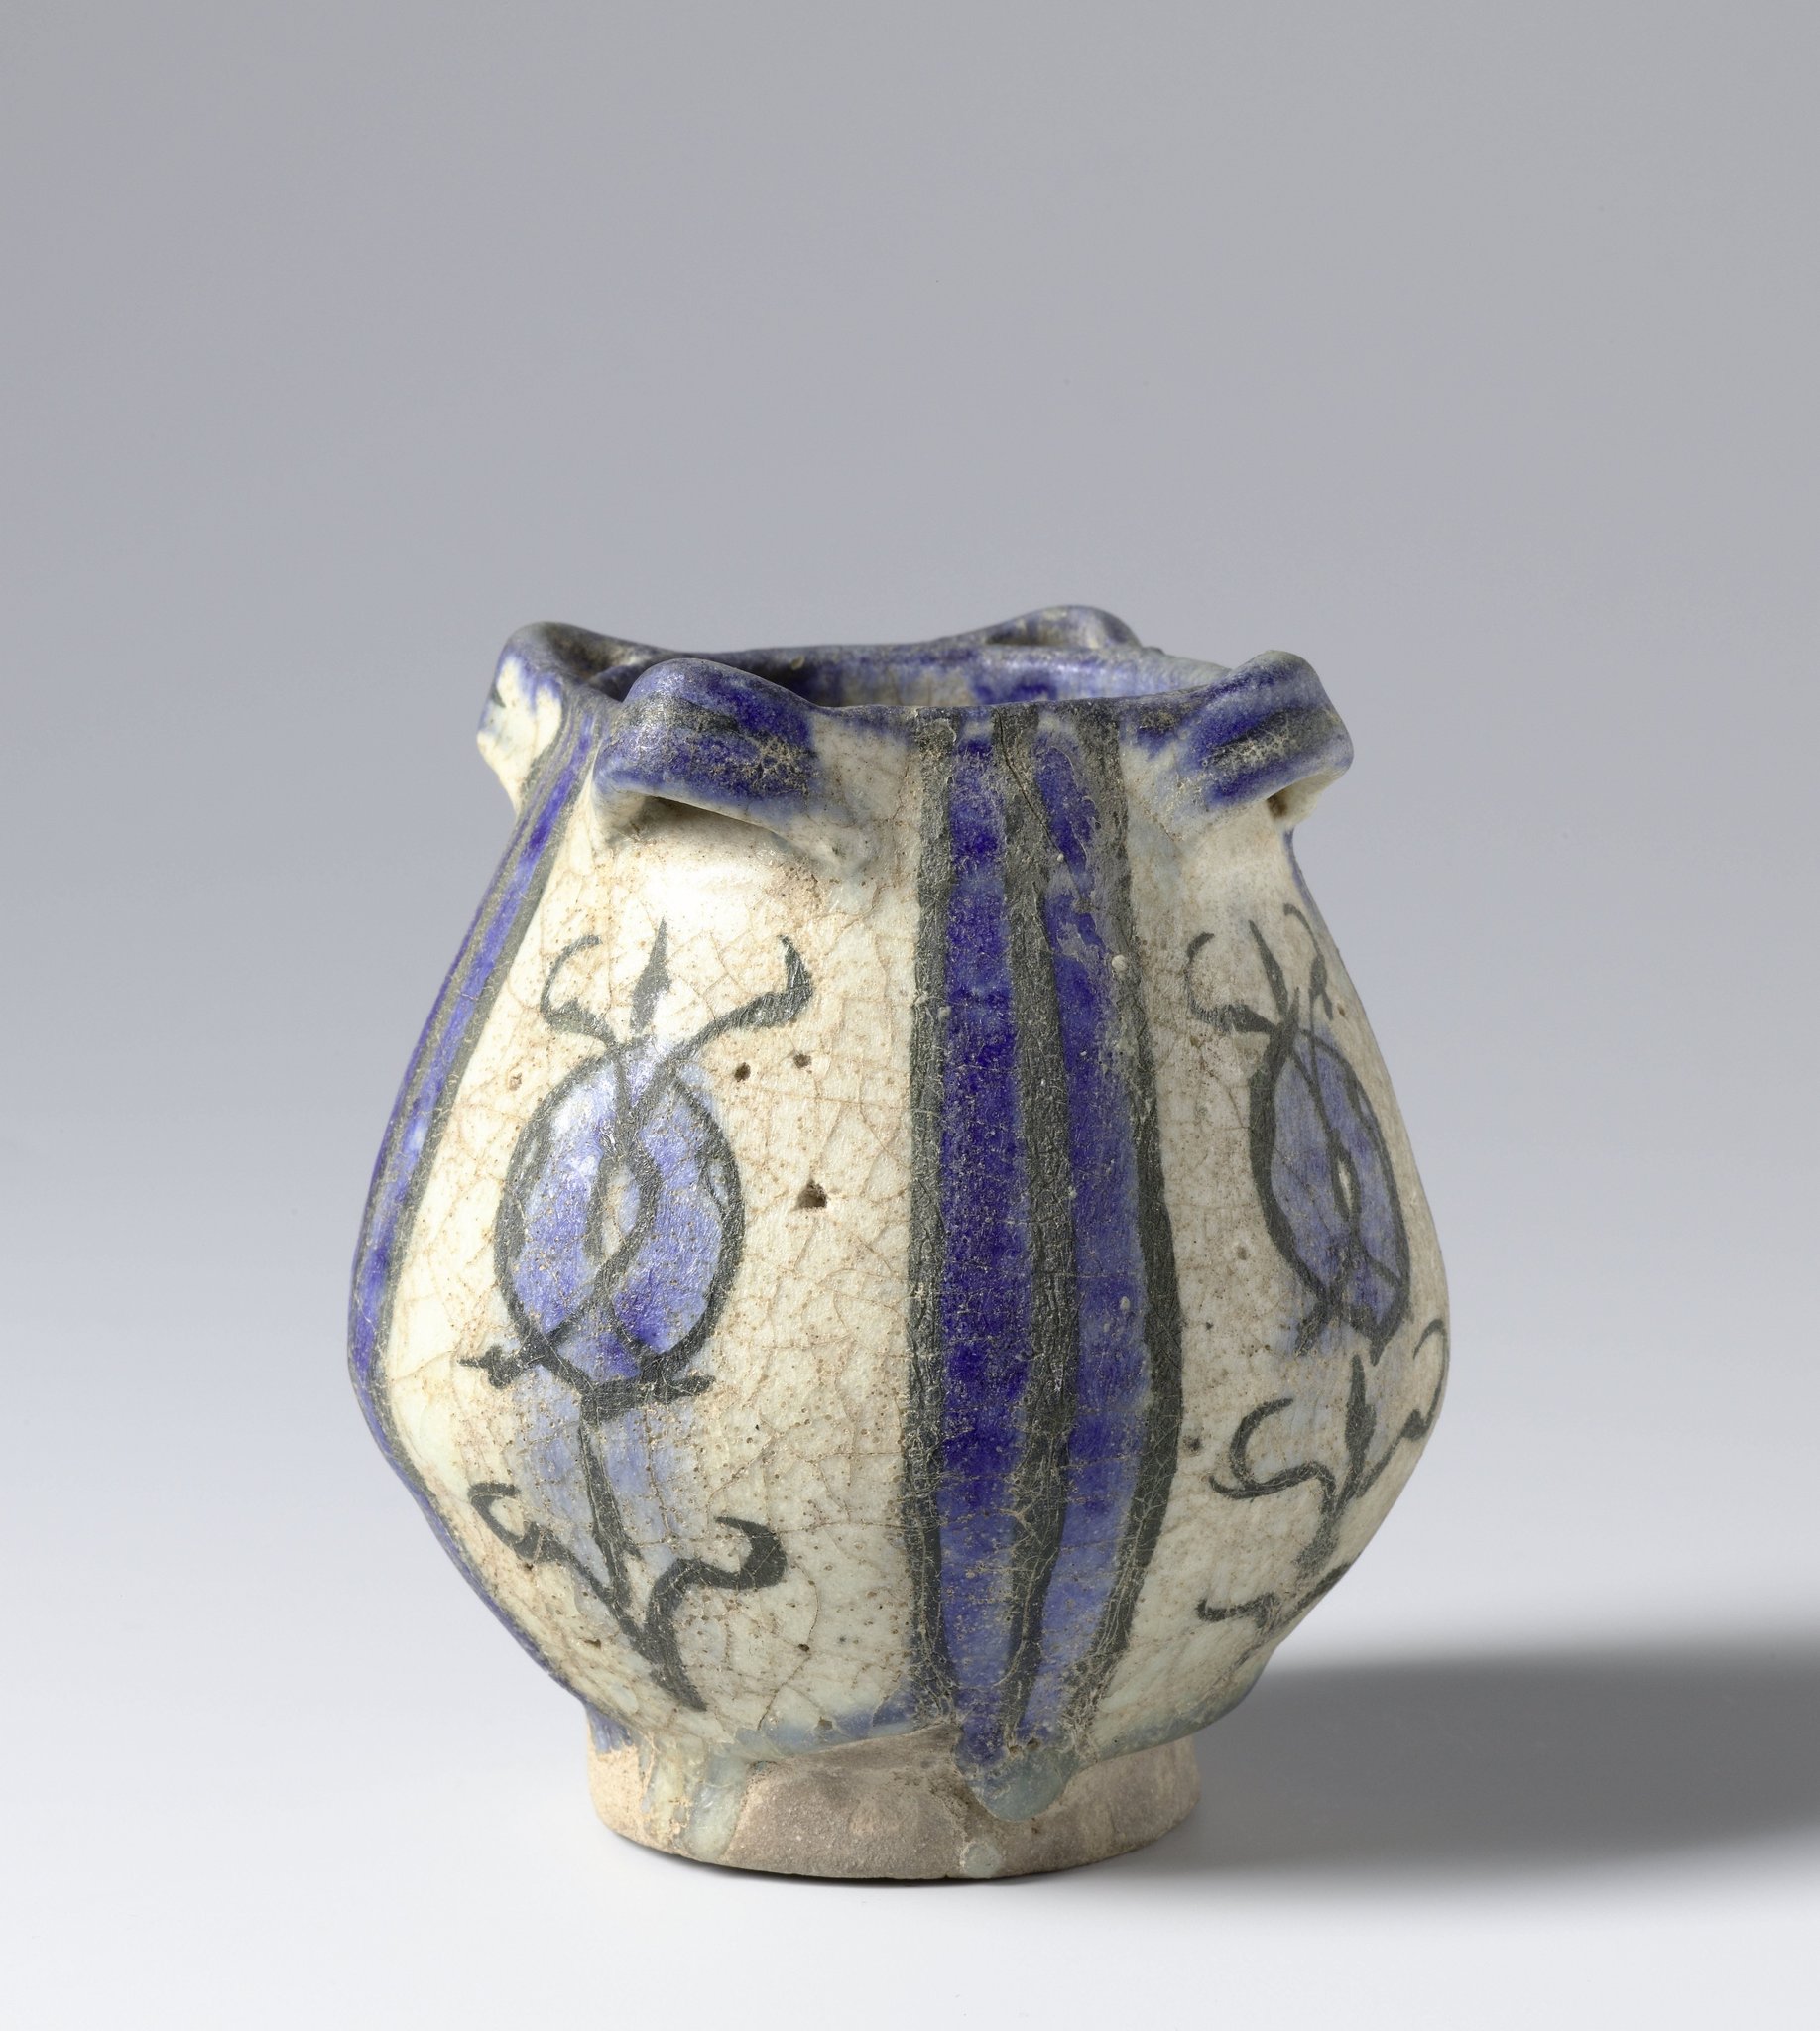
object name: bowl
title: Bowl with pseudo-inscription and stripes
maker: Anonymous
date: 1200-1299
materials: cobalt, earthenware, glaze, paint, quartz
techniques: engraving, firing, turning, vitrification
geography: iran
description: Kom van kwarts-fritgoed, beschilderd met strepen in blauw onder transparant alkaliglazuur en met rand van in zwart gegrift pseudo-schrift.